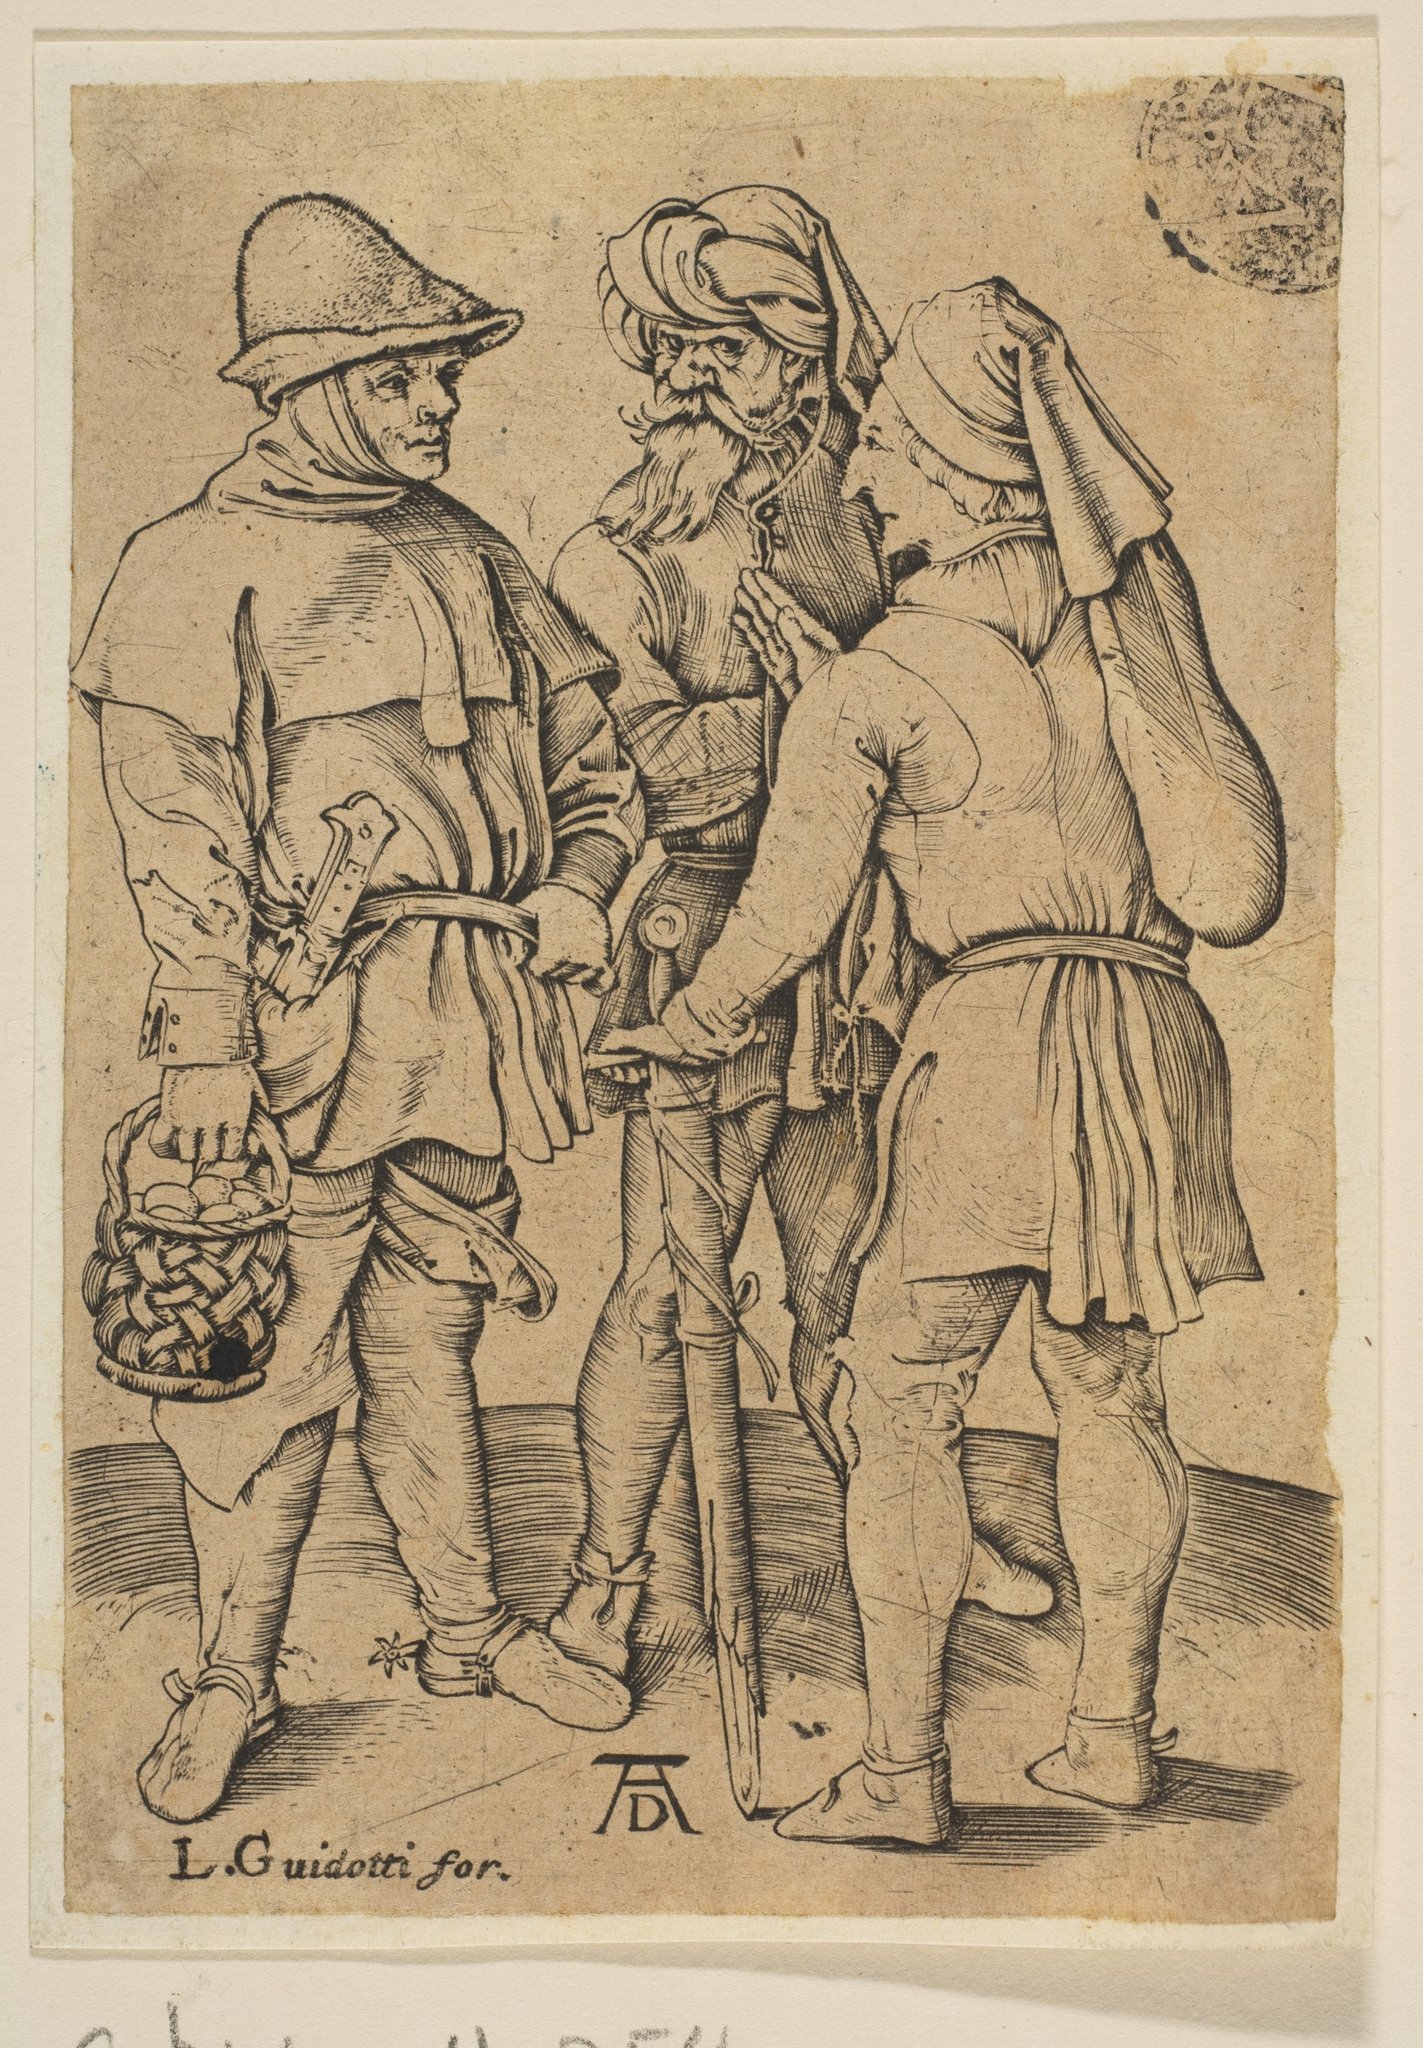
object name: print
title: Three Peasants in Conversation (reverse copy)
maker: albrecht dürer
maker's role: artist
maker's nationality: german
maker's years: 1471-1528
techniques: engraving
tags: swords,men